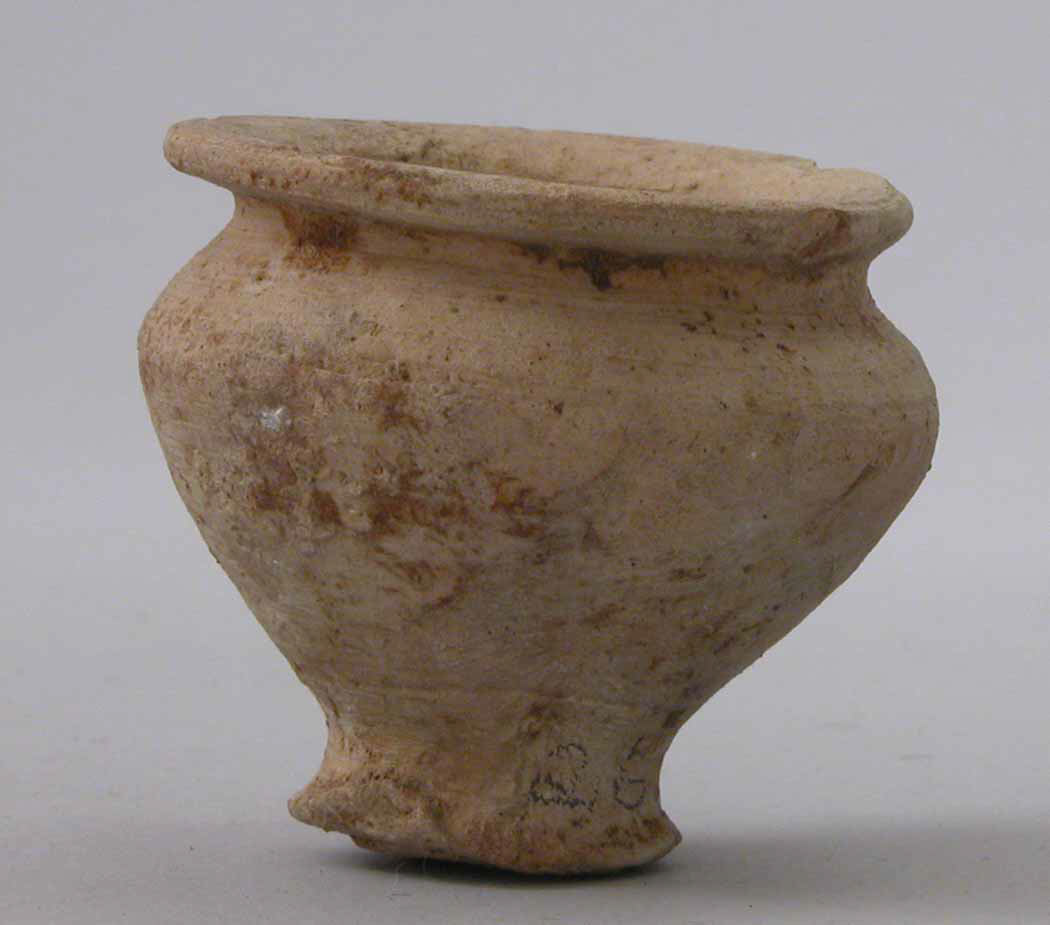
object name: jar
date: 701-900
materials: earthenware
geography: iran